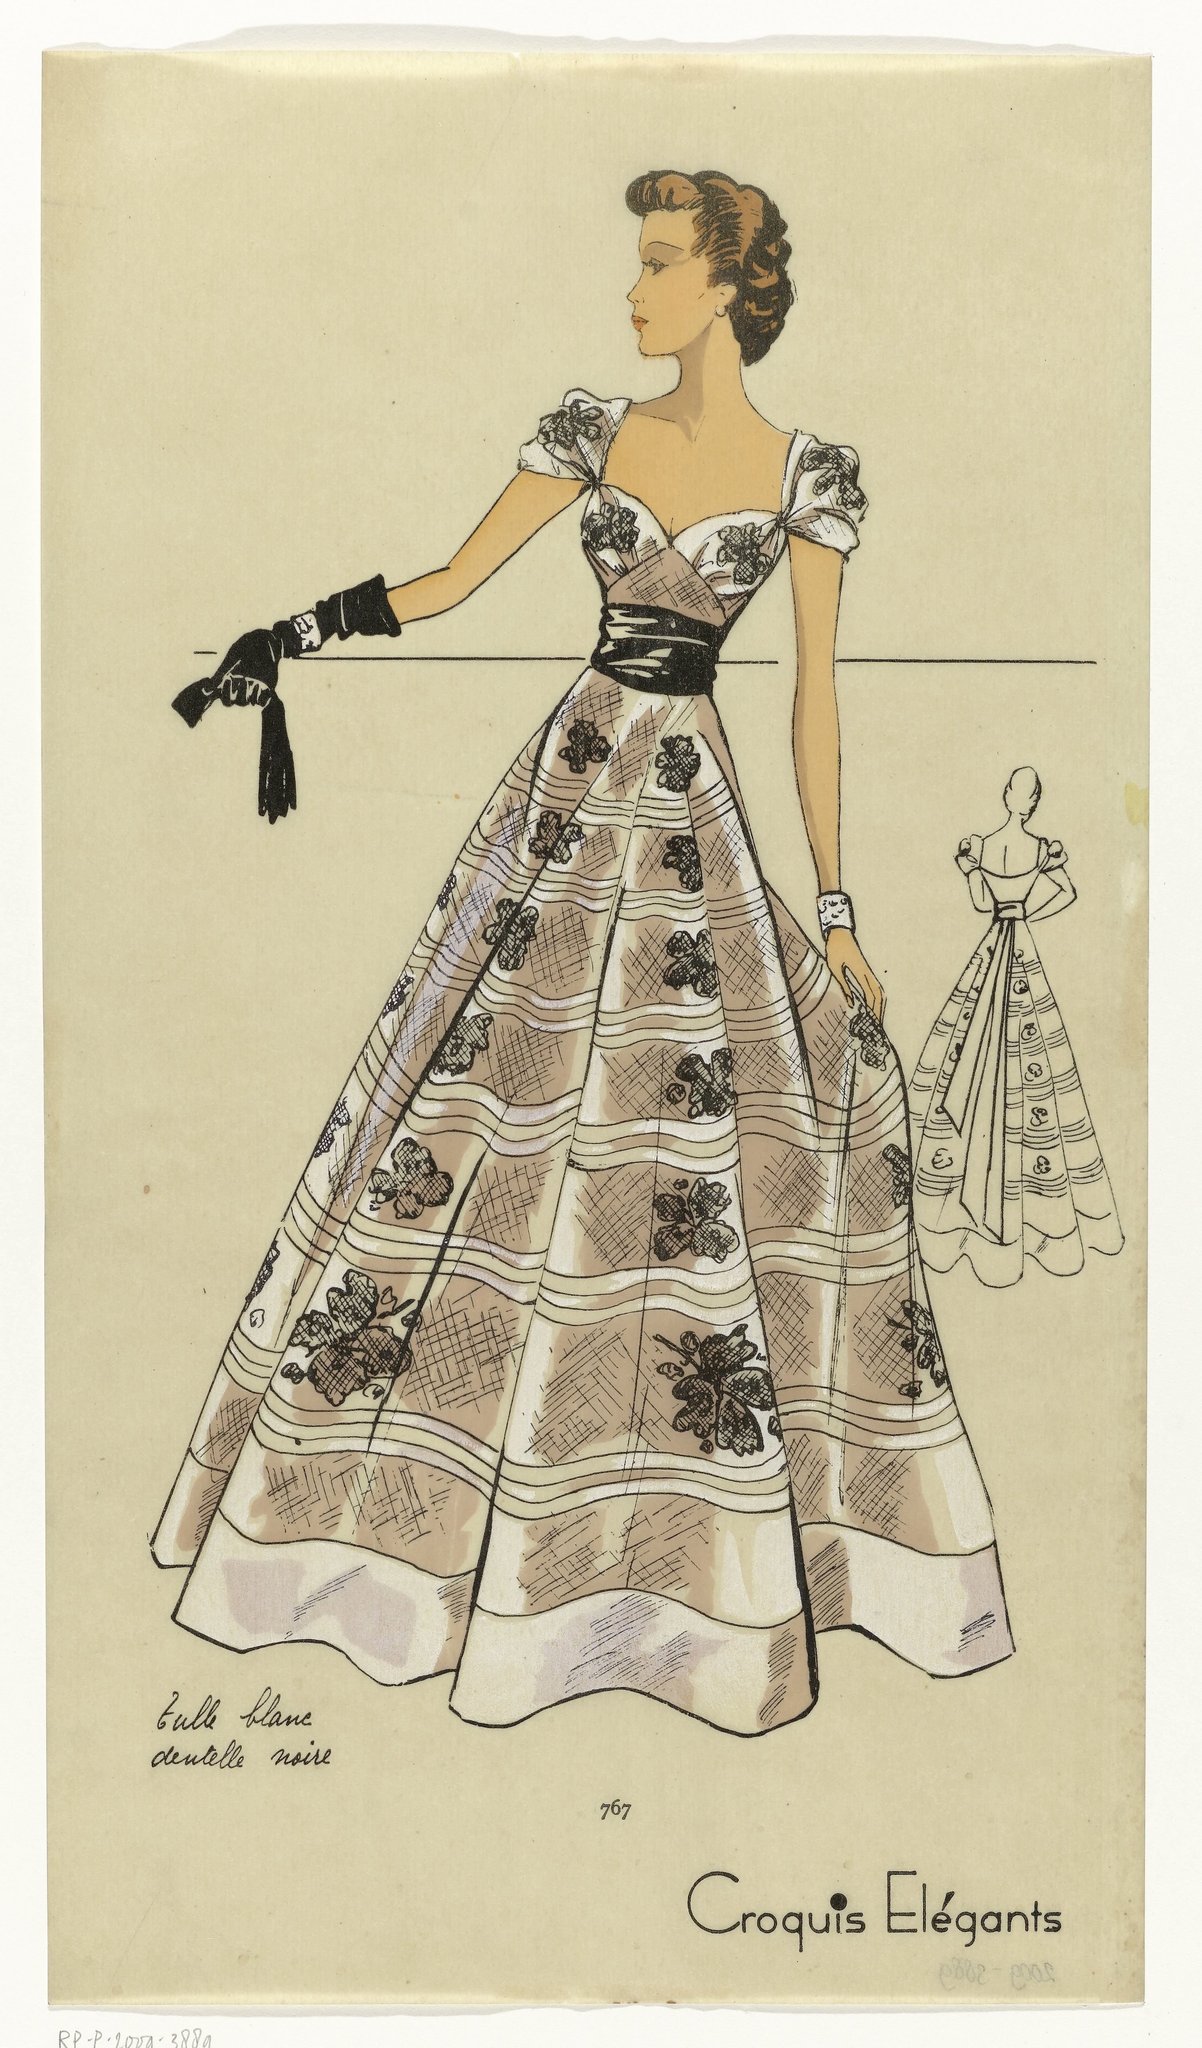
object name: fashion print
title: Croquis Elégants, 1939, No. 767 : Tule blanc dentelle noir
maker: Anonymous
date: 1939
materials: paper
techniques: engraving, hand coloring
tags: dress, gown: evening dress (+ women's clothes), fashion plates, gloves, mittens, etc. (+ women's clothes), dress, gown (+ women's clothes), bracelet, wristlet (+ women's clothes)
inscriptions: inscription: ‘tulle blanc / dentelle noire’, title: ‘Croquis Elégants’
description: Avondjapon van witte tule en zwarte kant. Prent uit het modetijdschrift Croquis Elégants (1931-...?).